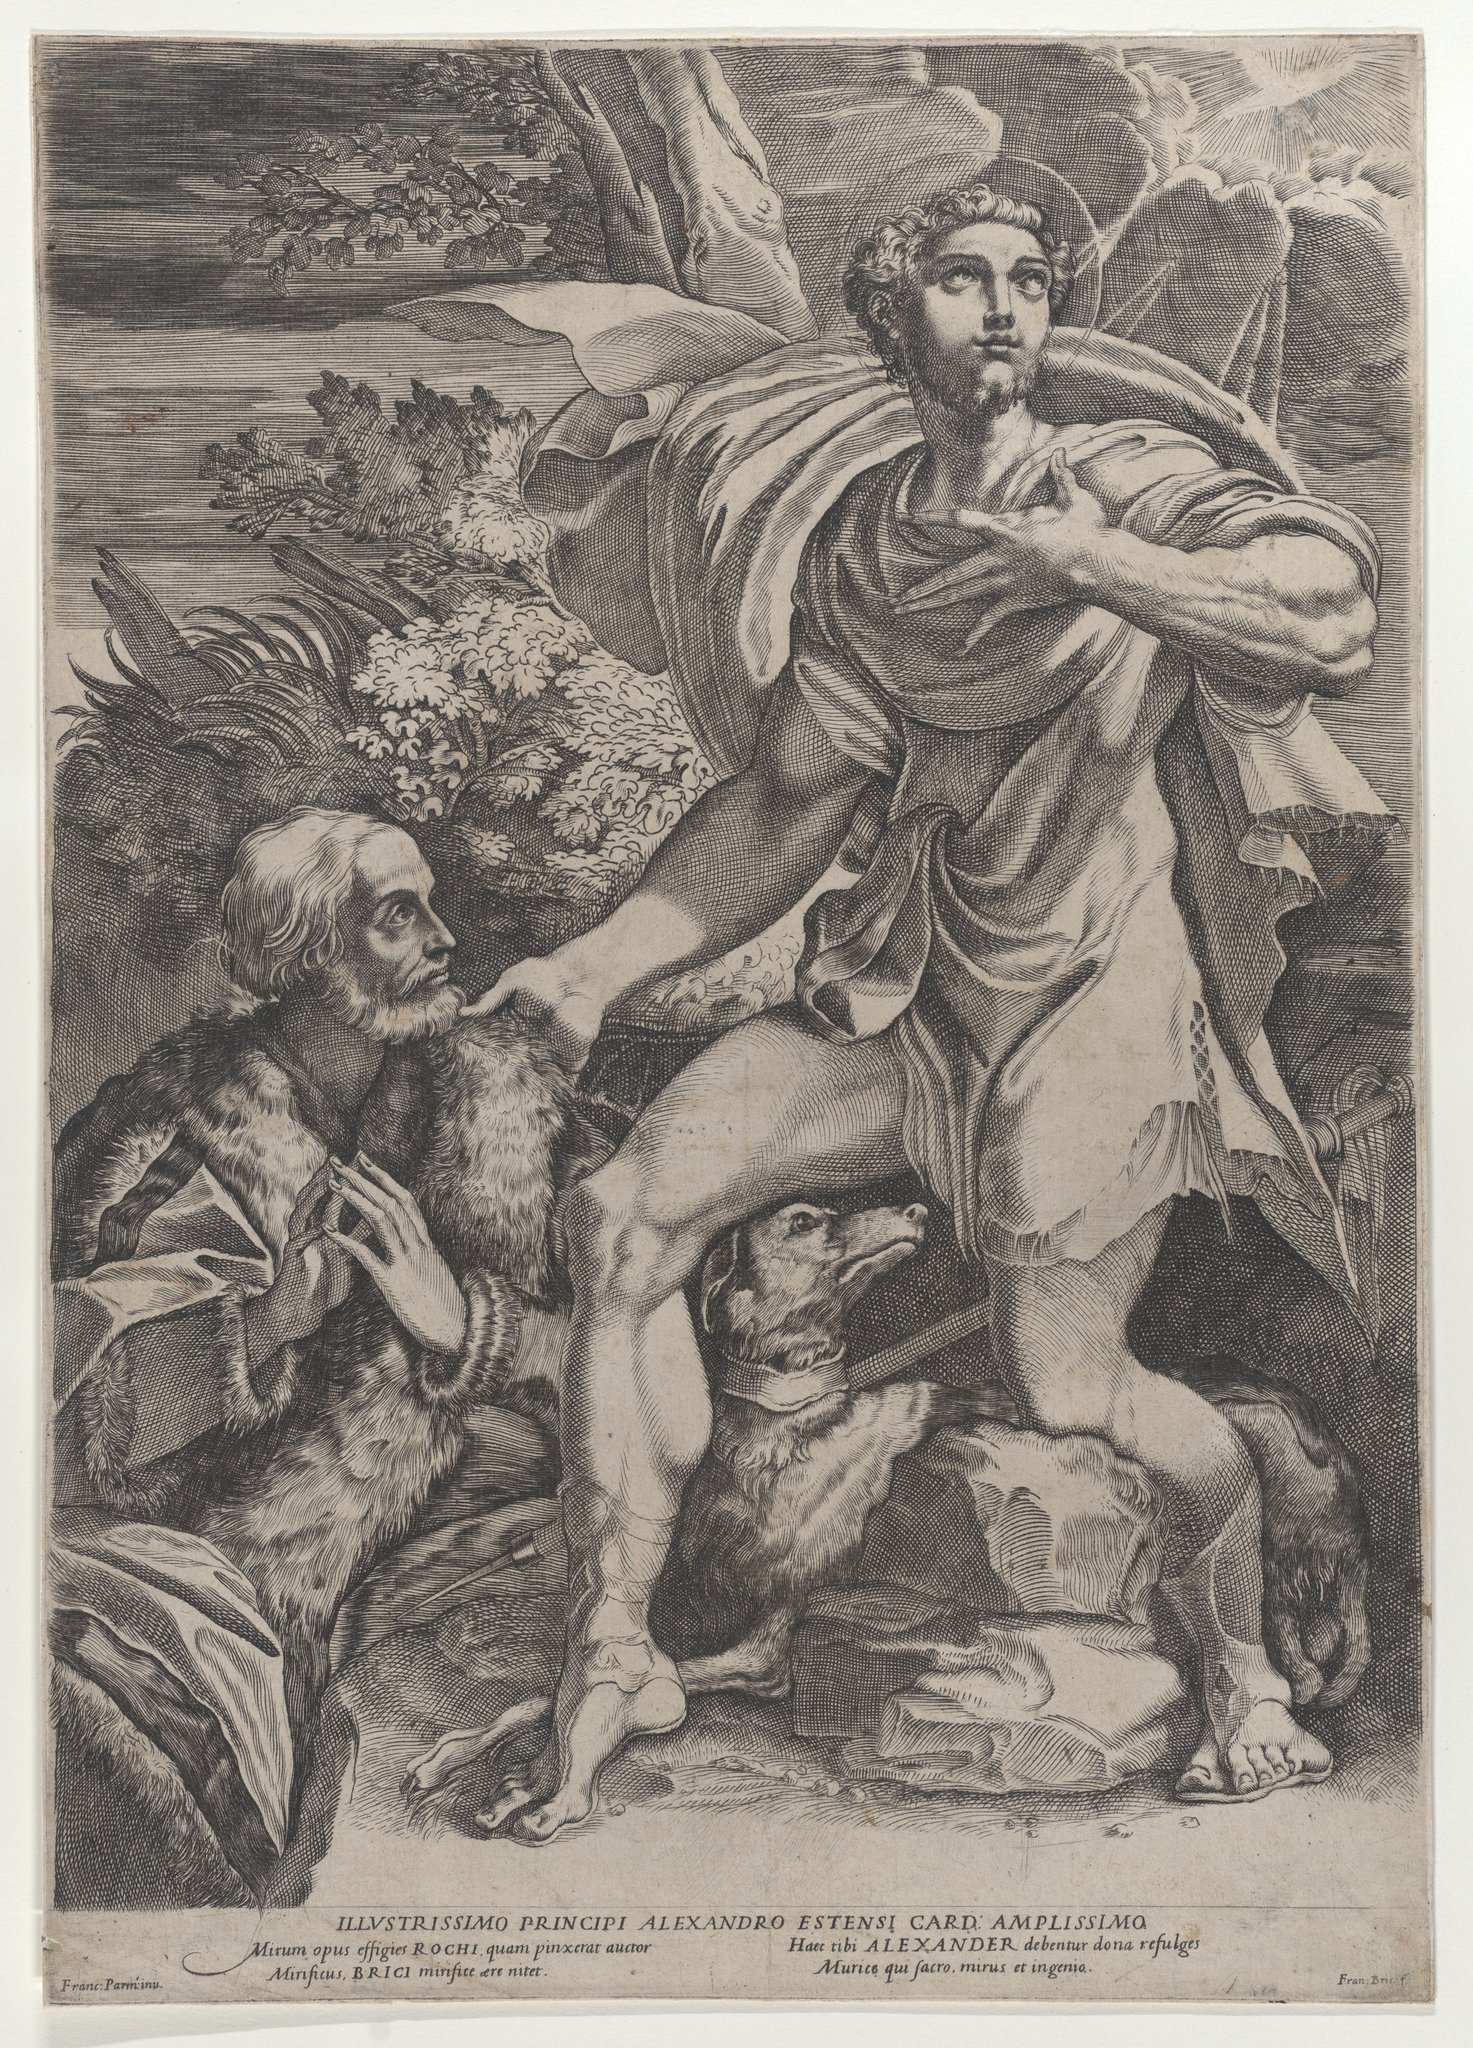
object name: print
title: Saint Roch with a donor and a dog at left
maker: francesco brizio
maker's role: artist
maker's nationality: italian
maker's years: 1569-1623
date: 1602-1603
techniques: engraving